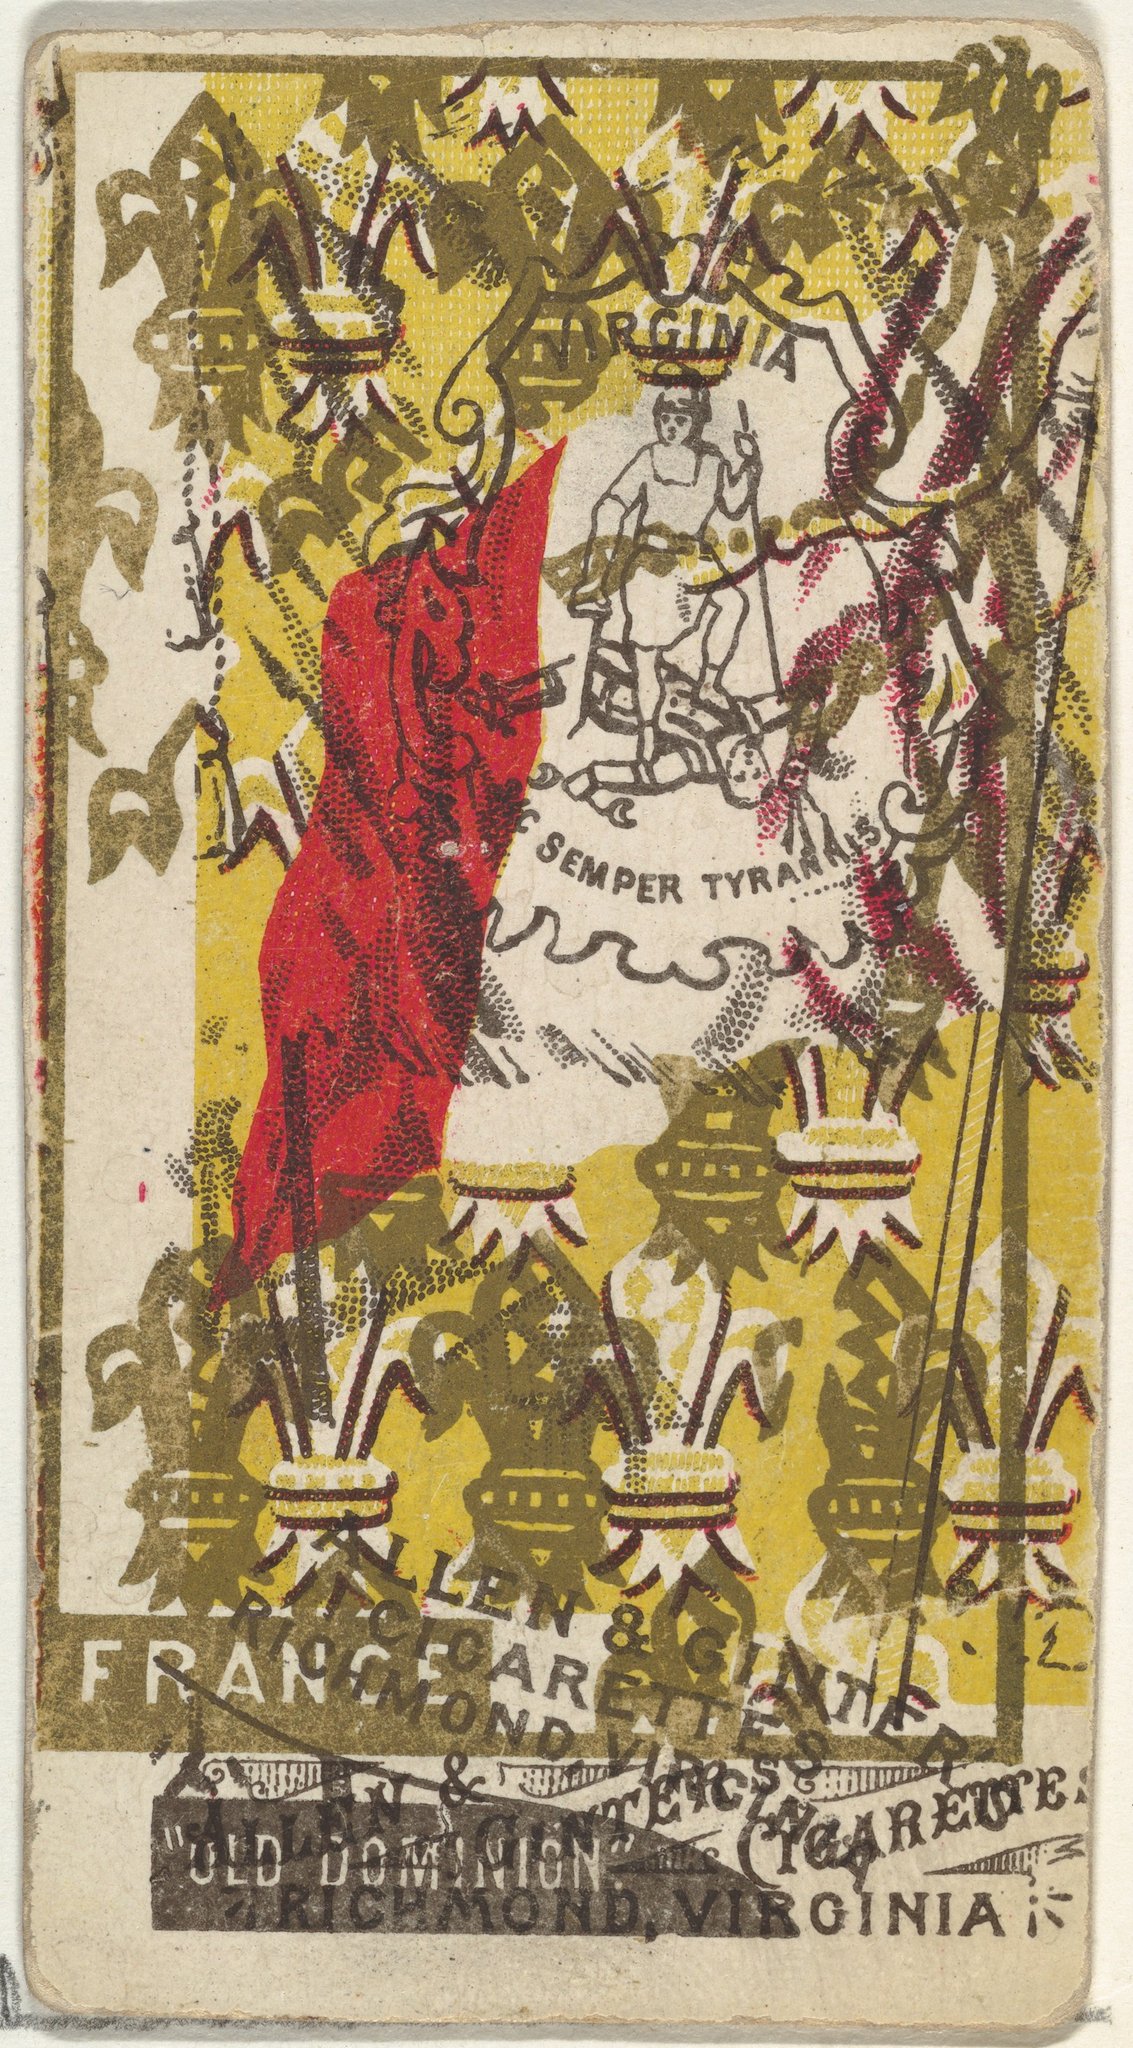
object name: print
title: Virginia and France (double-printed card), from Flags of All Nations, Series 1 (N9) for Allen & Ginter Cigarettes Brands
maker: allen & ginter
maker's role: publisher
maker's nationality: american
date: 1887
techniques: color lithograph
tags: flags